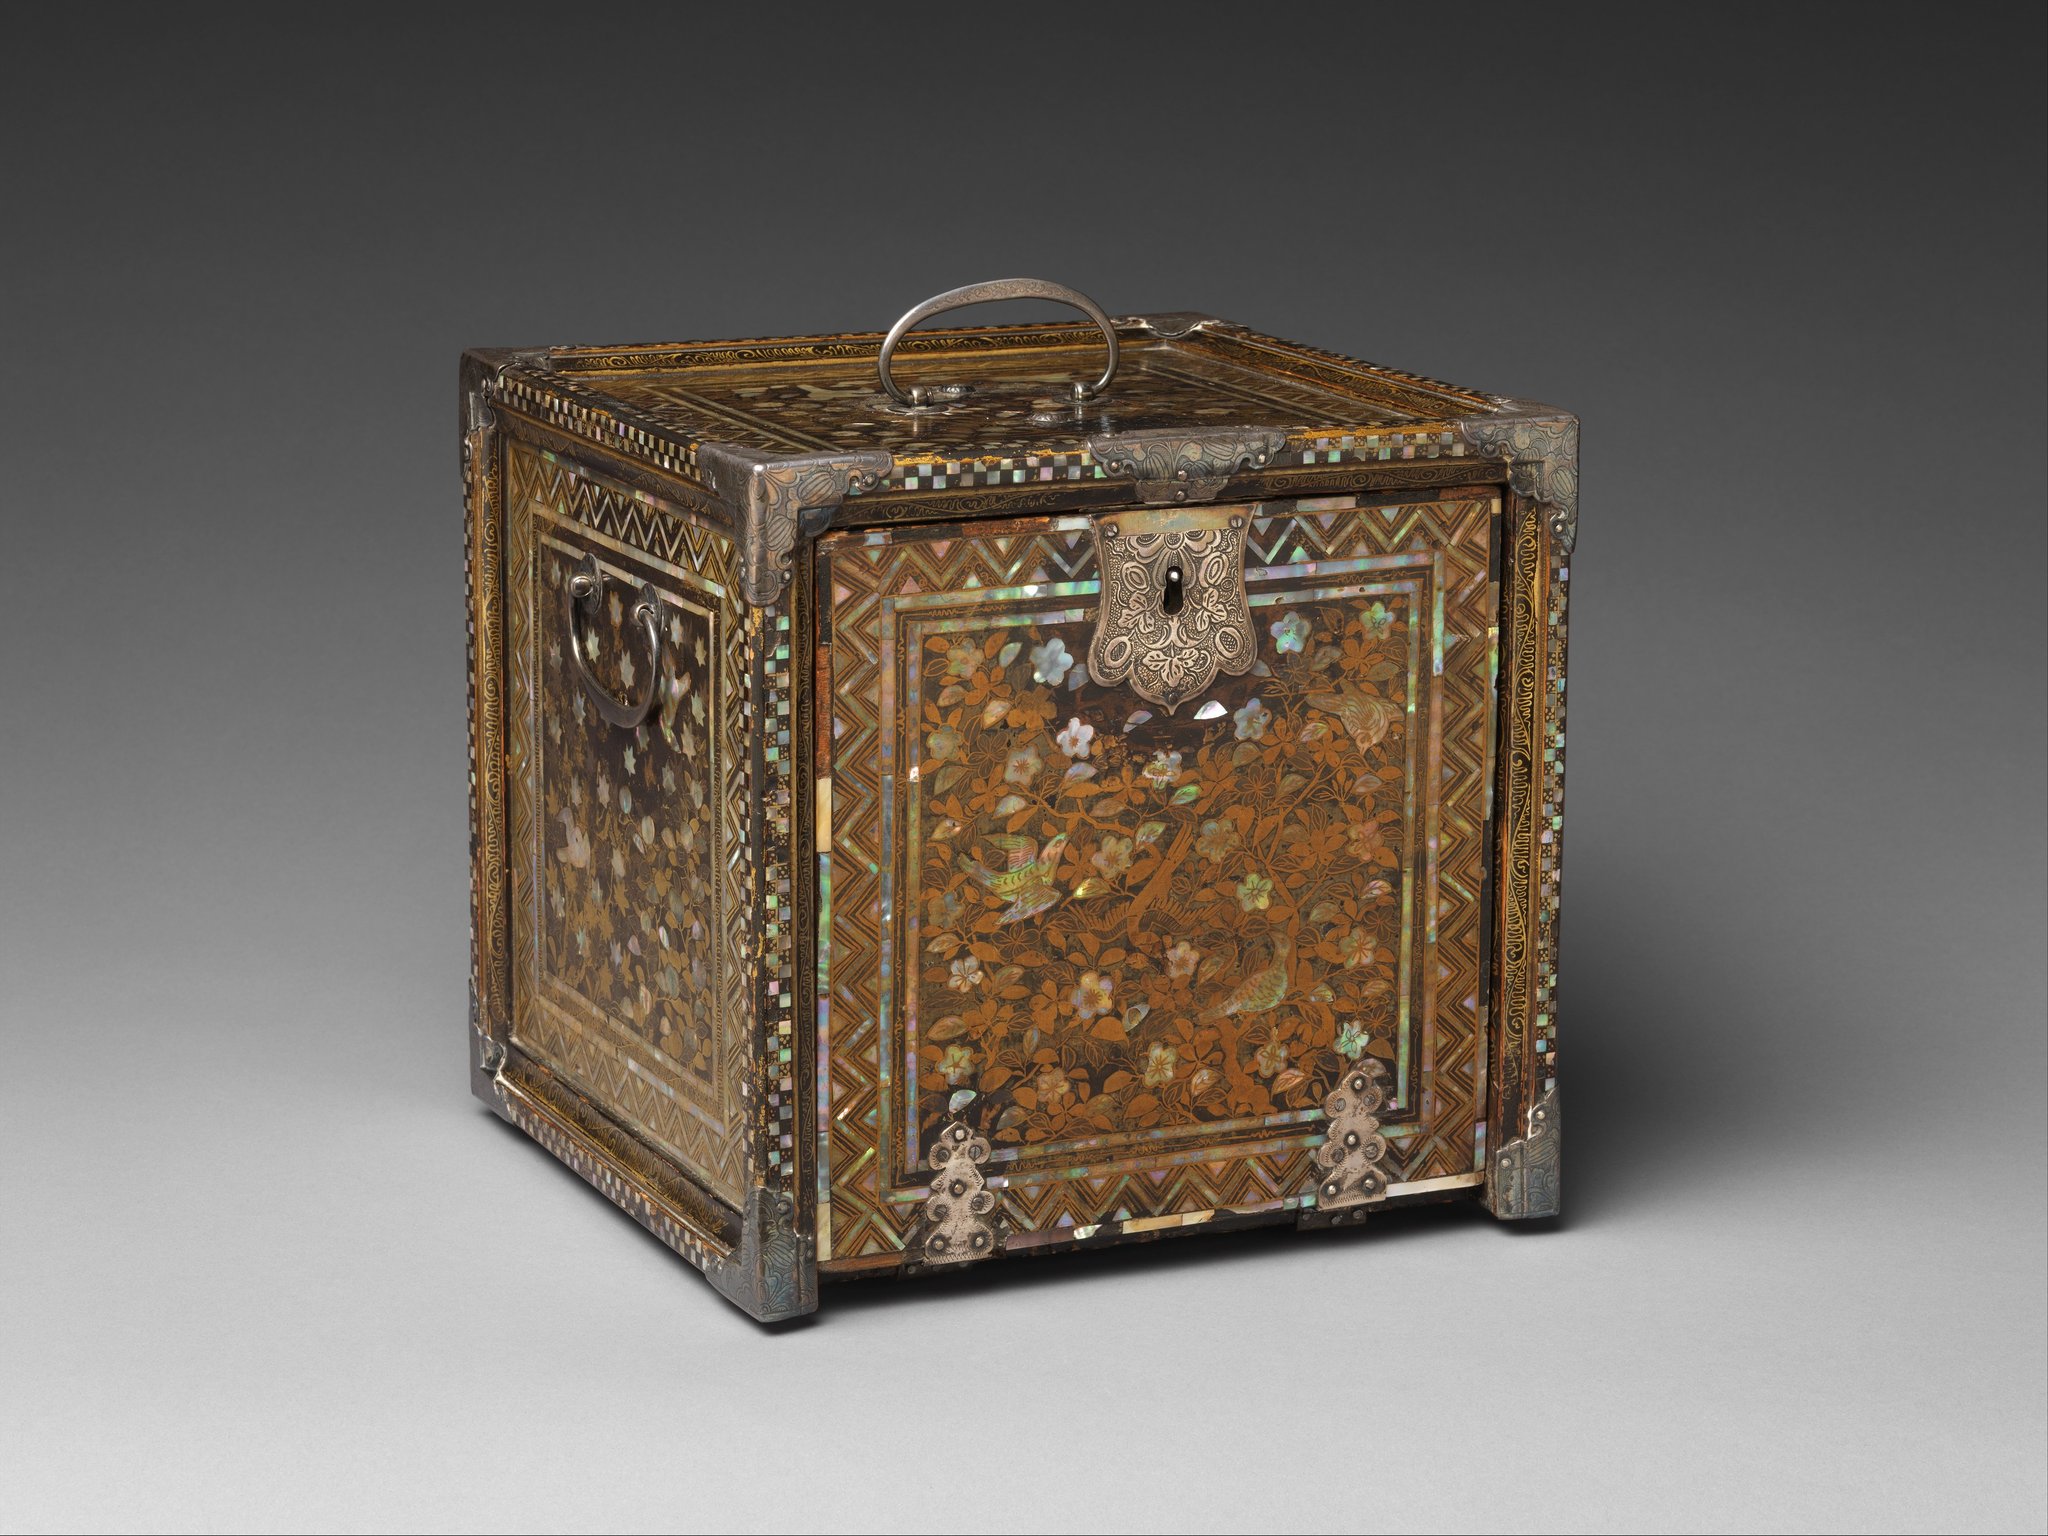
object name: cabinet with drawer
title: Portable Cabinet with Drawers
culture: japanese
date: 1501-1600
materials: gold, lacquer, mother of pearl, silver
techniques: inlay, maki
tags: cabinets